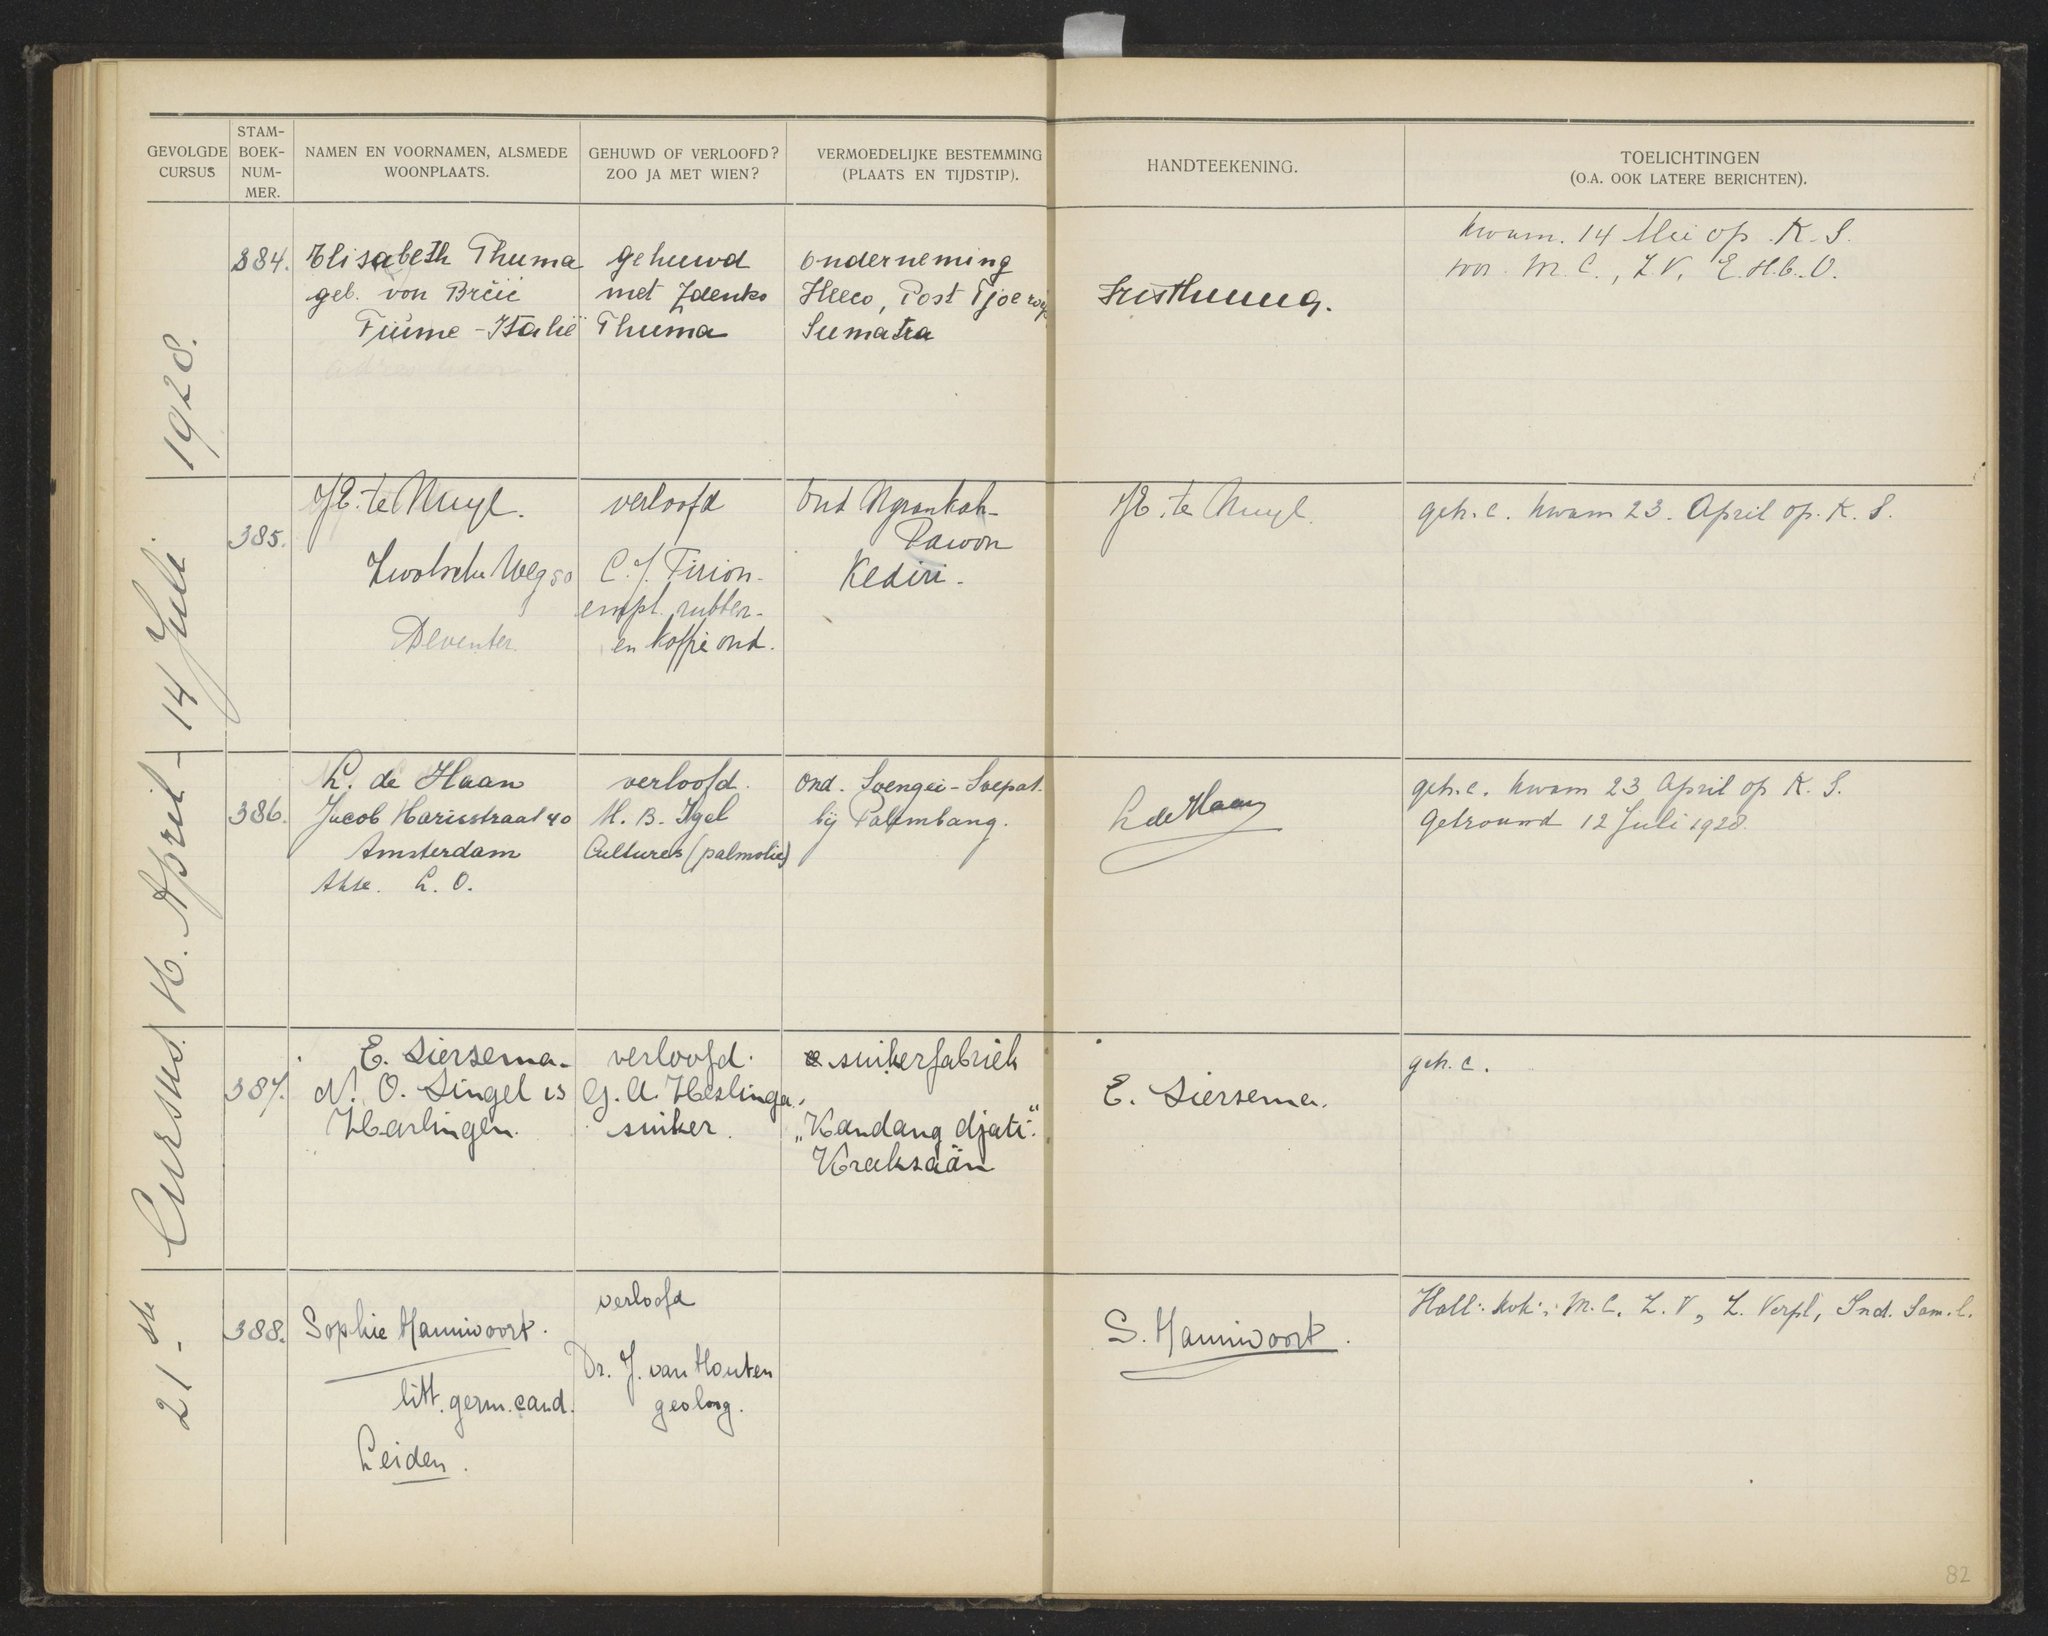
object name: album leaf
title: Blad 82 uit Stamboek van de leerlingen der Koloniale School voor Meisjes en Vrouwen te 's-Gravenhage deel I (1921-1929)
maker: Anonymous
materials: paper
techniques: printing, writing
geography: the hague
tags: further education (+ pupil), further education, the hague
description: Twee pagina's met gegevens van de deelnemers aan de 21e driemaandelijkse cursus van 16 april tot en met 14 juli 1928, stamboeknummers 384 tot en met 388. Onderdeel van Stamboek van de leerlingen der Koloniale School voor Meisjes en Vrouwen te 's-Gravenhage deel I (1921-1929).